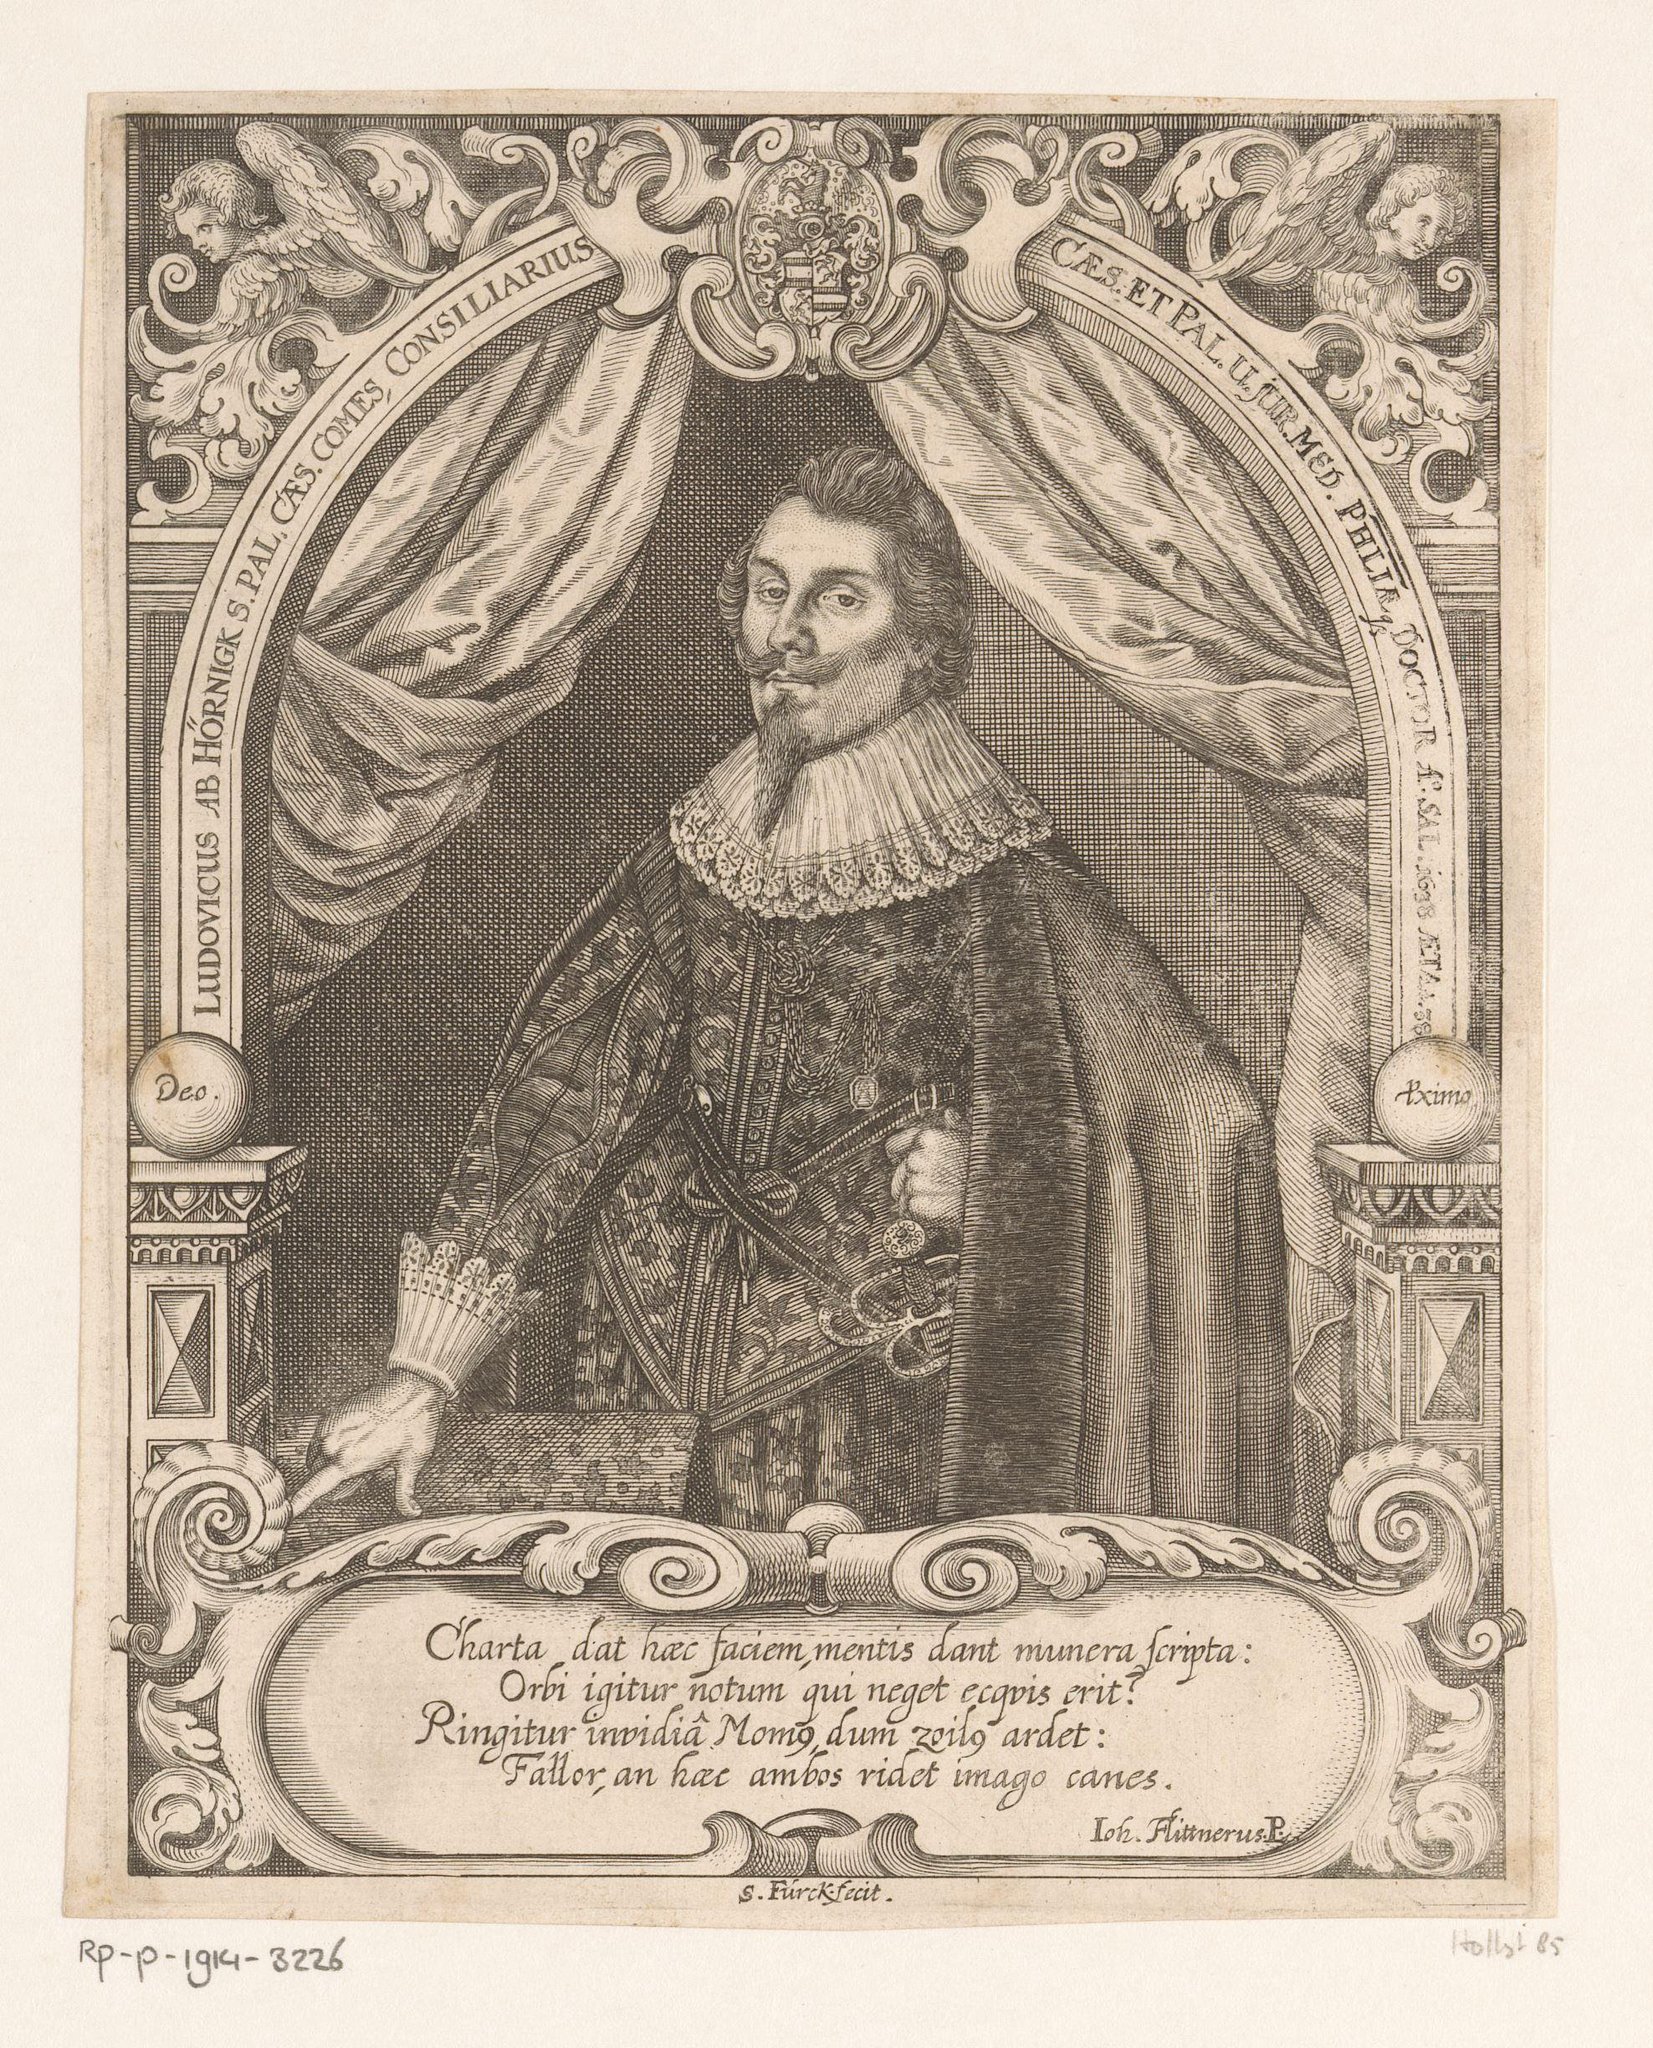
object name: print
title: Portret van Ludwig von Hörnigk op 38-jarige leeftijd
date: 1638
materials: paper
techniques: engraving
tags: cherubs, i.e. children's heads with wings, historical persons, ornament ~ cartouche, ornament derived from architectural details, armorial bearing, heraldry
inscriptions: collector's mark: Lugt 2228